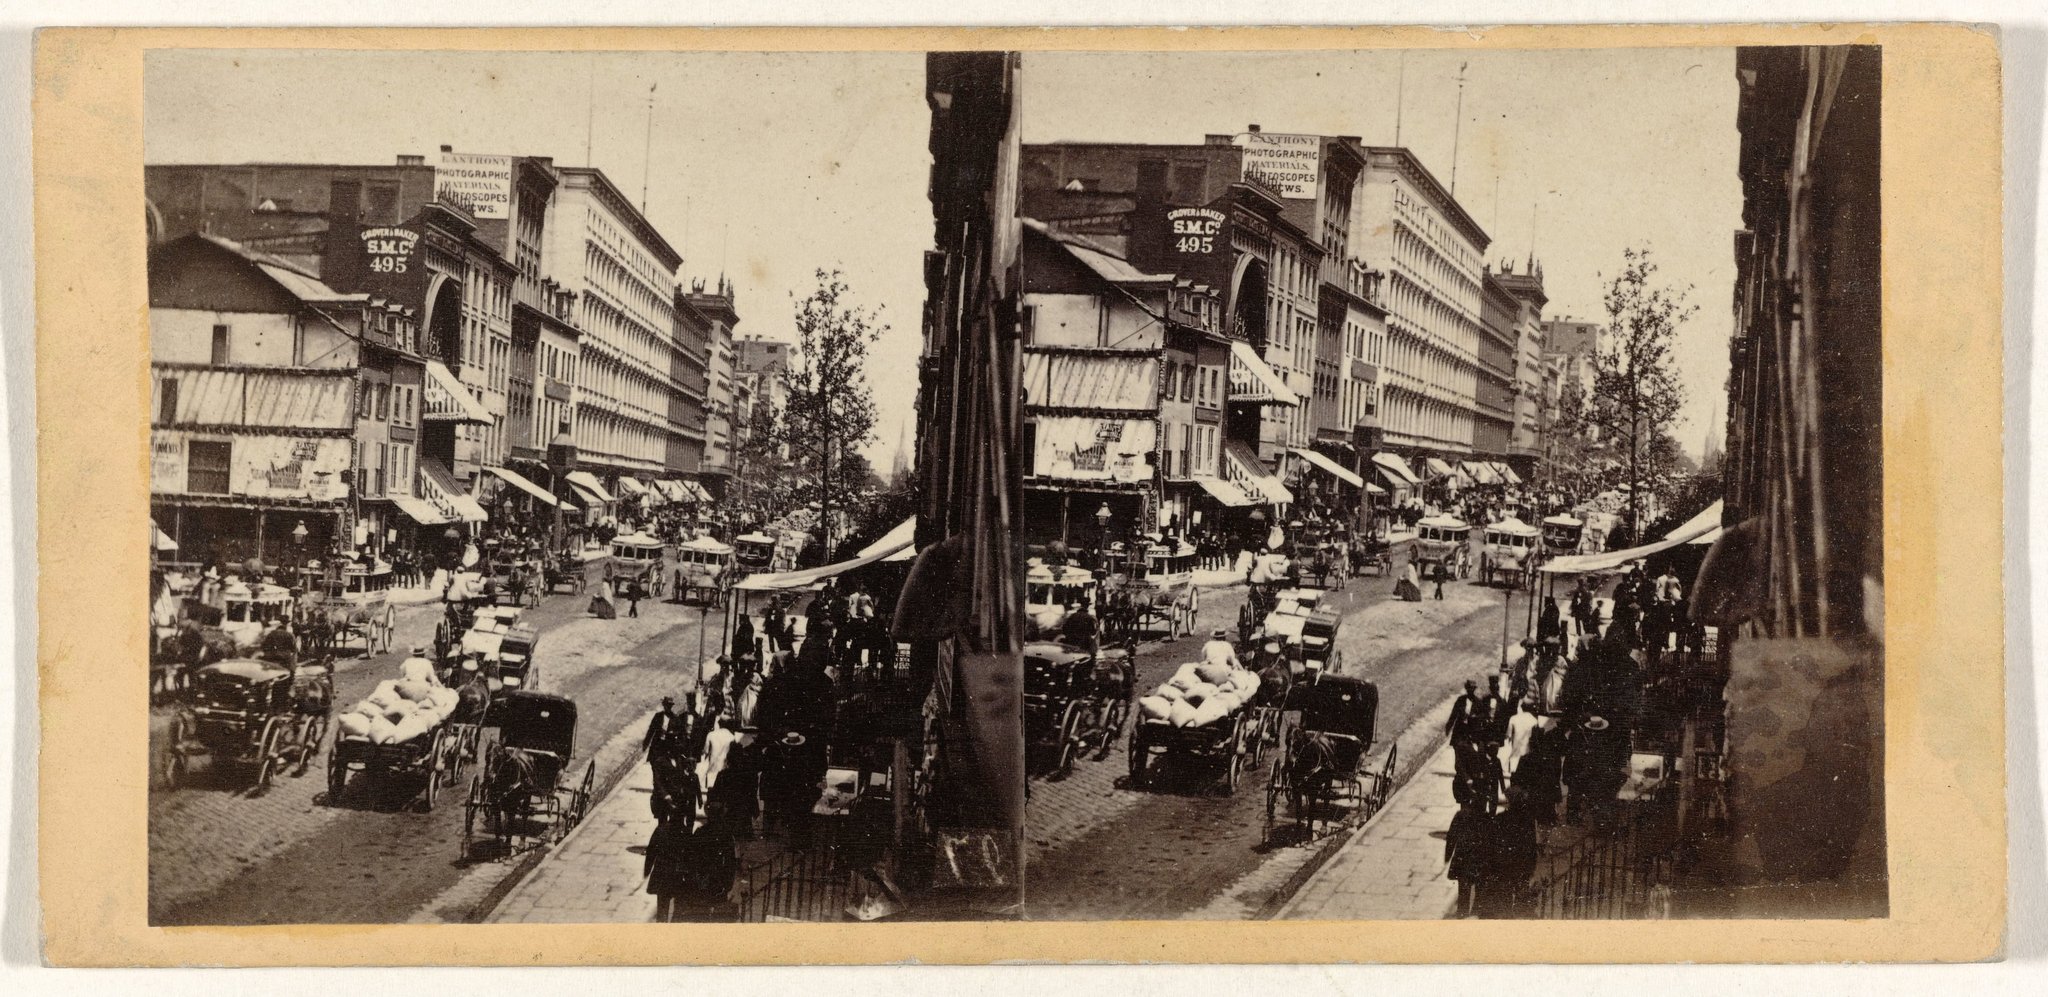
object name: stereograph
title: Up Broadway from the Pacific Bank in New York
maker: edward anthony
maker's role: publisher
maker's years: 1819-1888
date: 1860-1863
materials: cardboard, paper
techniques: albumen print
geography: new york city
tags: animal traction, animal-drawn vehicle (carriage etc.), urban housing, street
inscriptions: inscription: ‘foto gemaakt en later gedrukt/ tussen 1860 (verhuizing naar no 501) en 1863: [...]’, number: ‘No. 79.’, inscription: ‘RBK’, address: ‘Published by E. Anthony, 501 Broadway, New-York.’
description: Op de foto is een plakkaat te zien met de tekst 'E. Anthony, photographic materials, stereoscopes, views'.